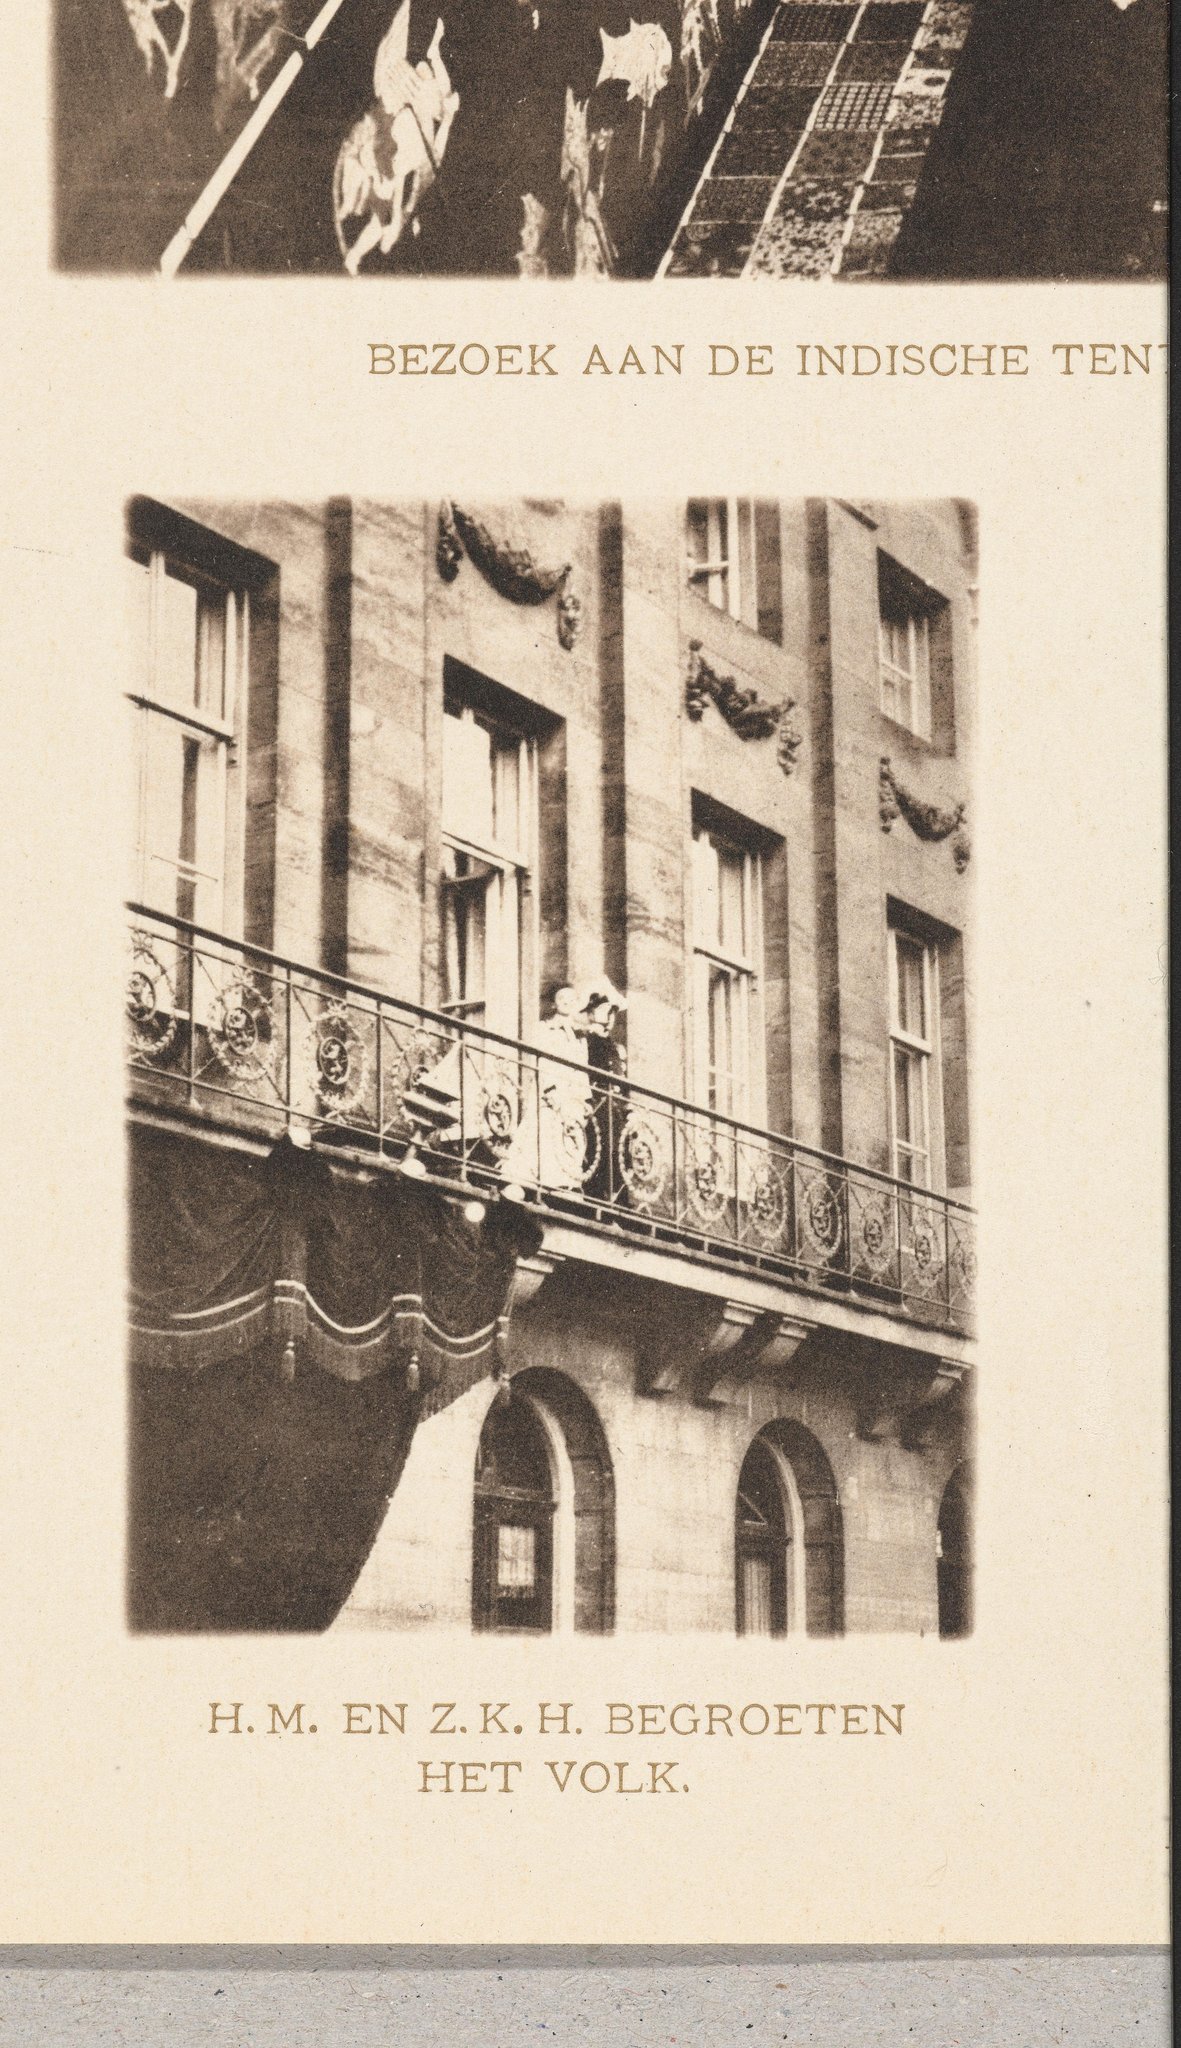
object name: photograph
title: Het koninklijk paar op het balkon van het Paleis op de Dam, Amsterdam, 5 maart 1901, feestelijkheden ter gelegenheid van het huwelijk van koningin Wilhelmina en prins Hendrik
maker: barend groote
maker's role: fotograaf, fotohandel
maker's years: 1862-1946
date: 1901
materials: paper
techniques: photograph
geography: amsterdam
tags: the hague, print maker, wilhelmina of the netherlands, hendrik (prins der nederlanden (1876-1934)), square, place, circus, etc., balcony, historical events and situations, royal palace of amsterdam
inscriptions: annotation: ‘H.M. en Z.K.H. begroeten het volk.’